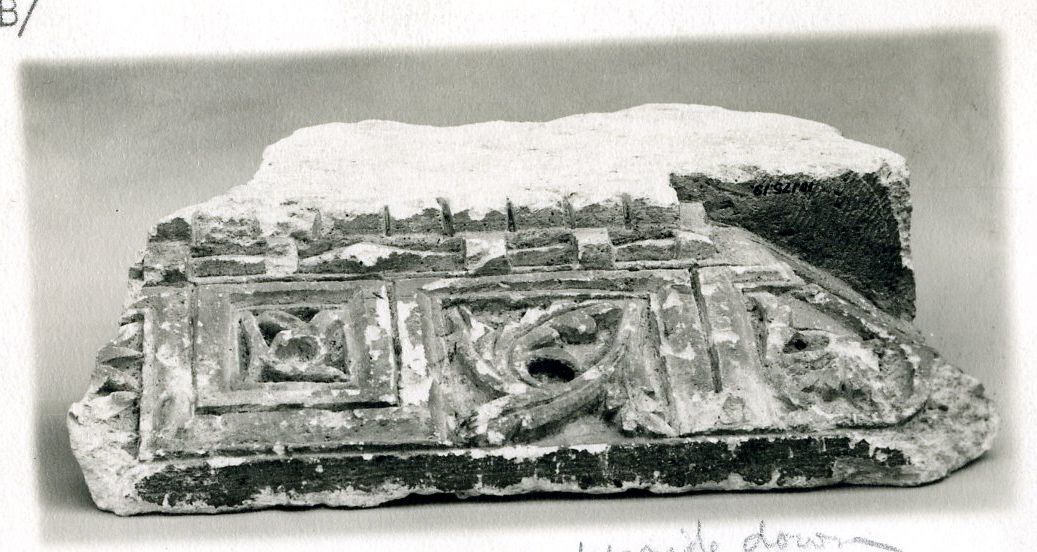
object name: fragment of a cornice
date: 501-700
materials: limestone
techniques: carving, relief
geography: egypt